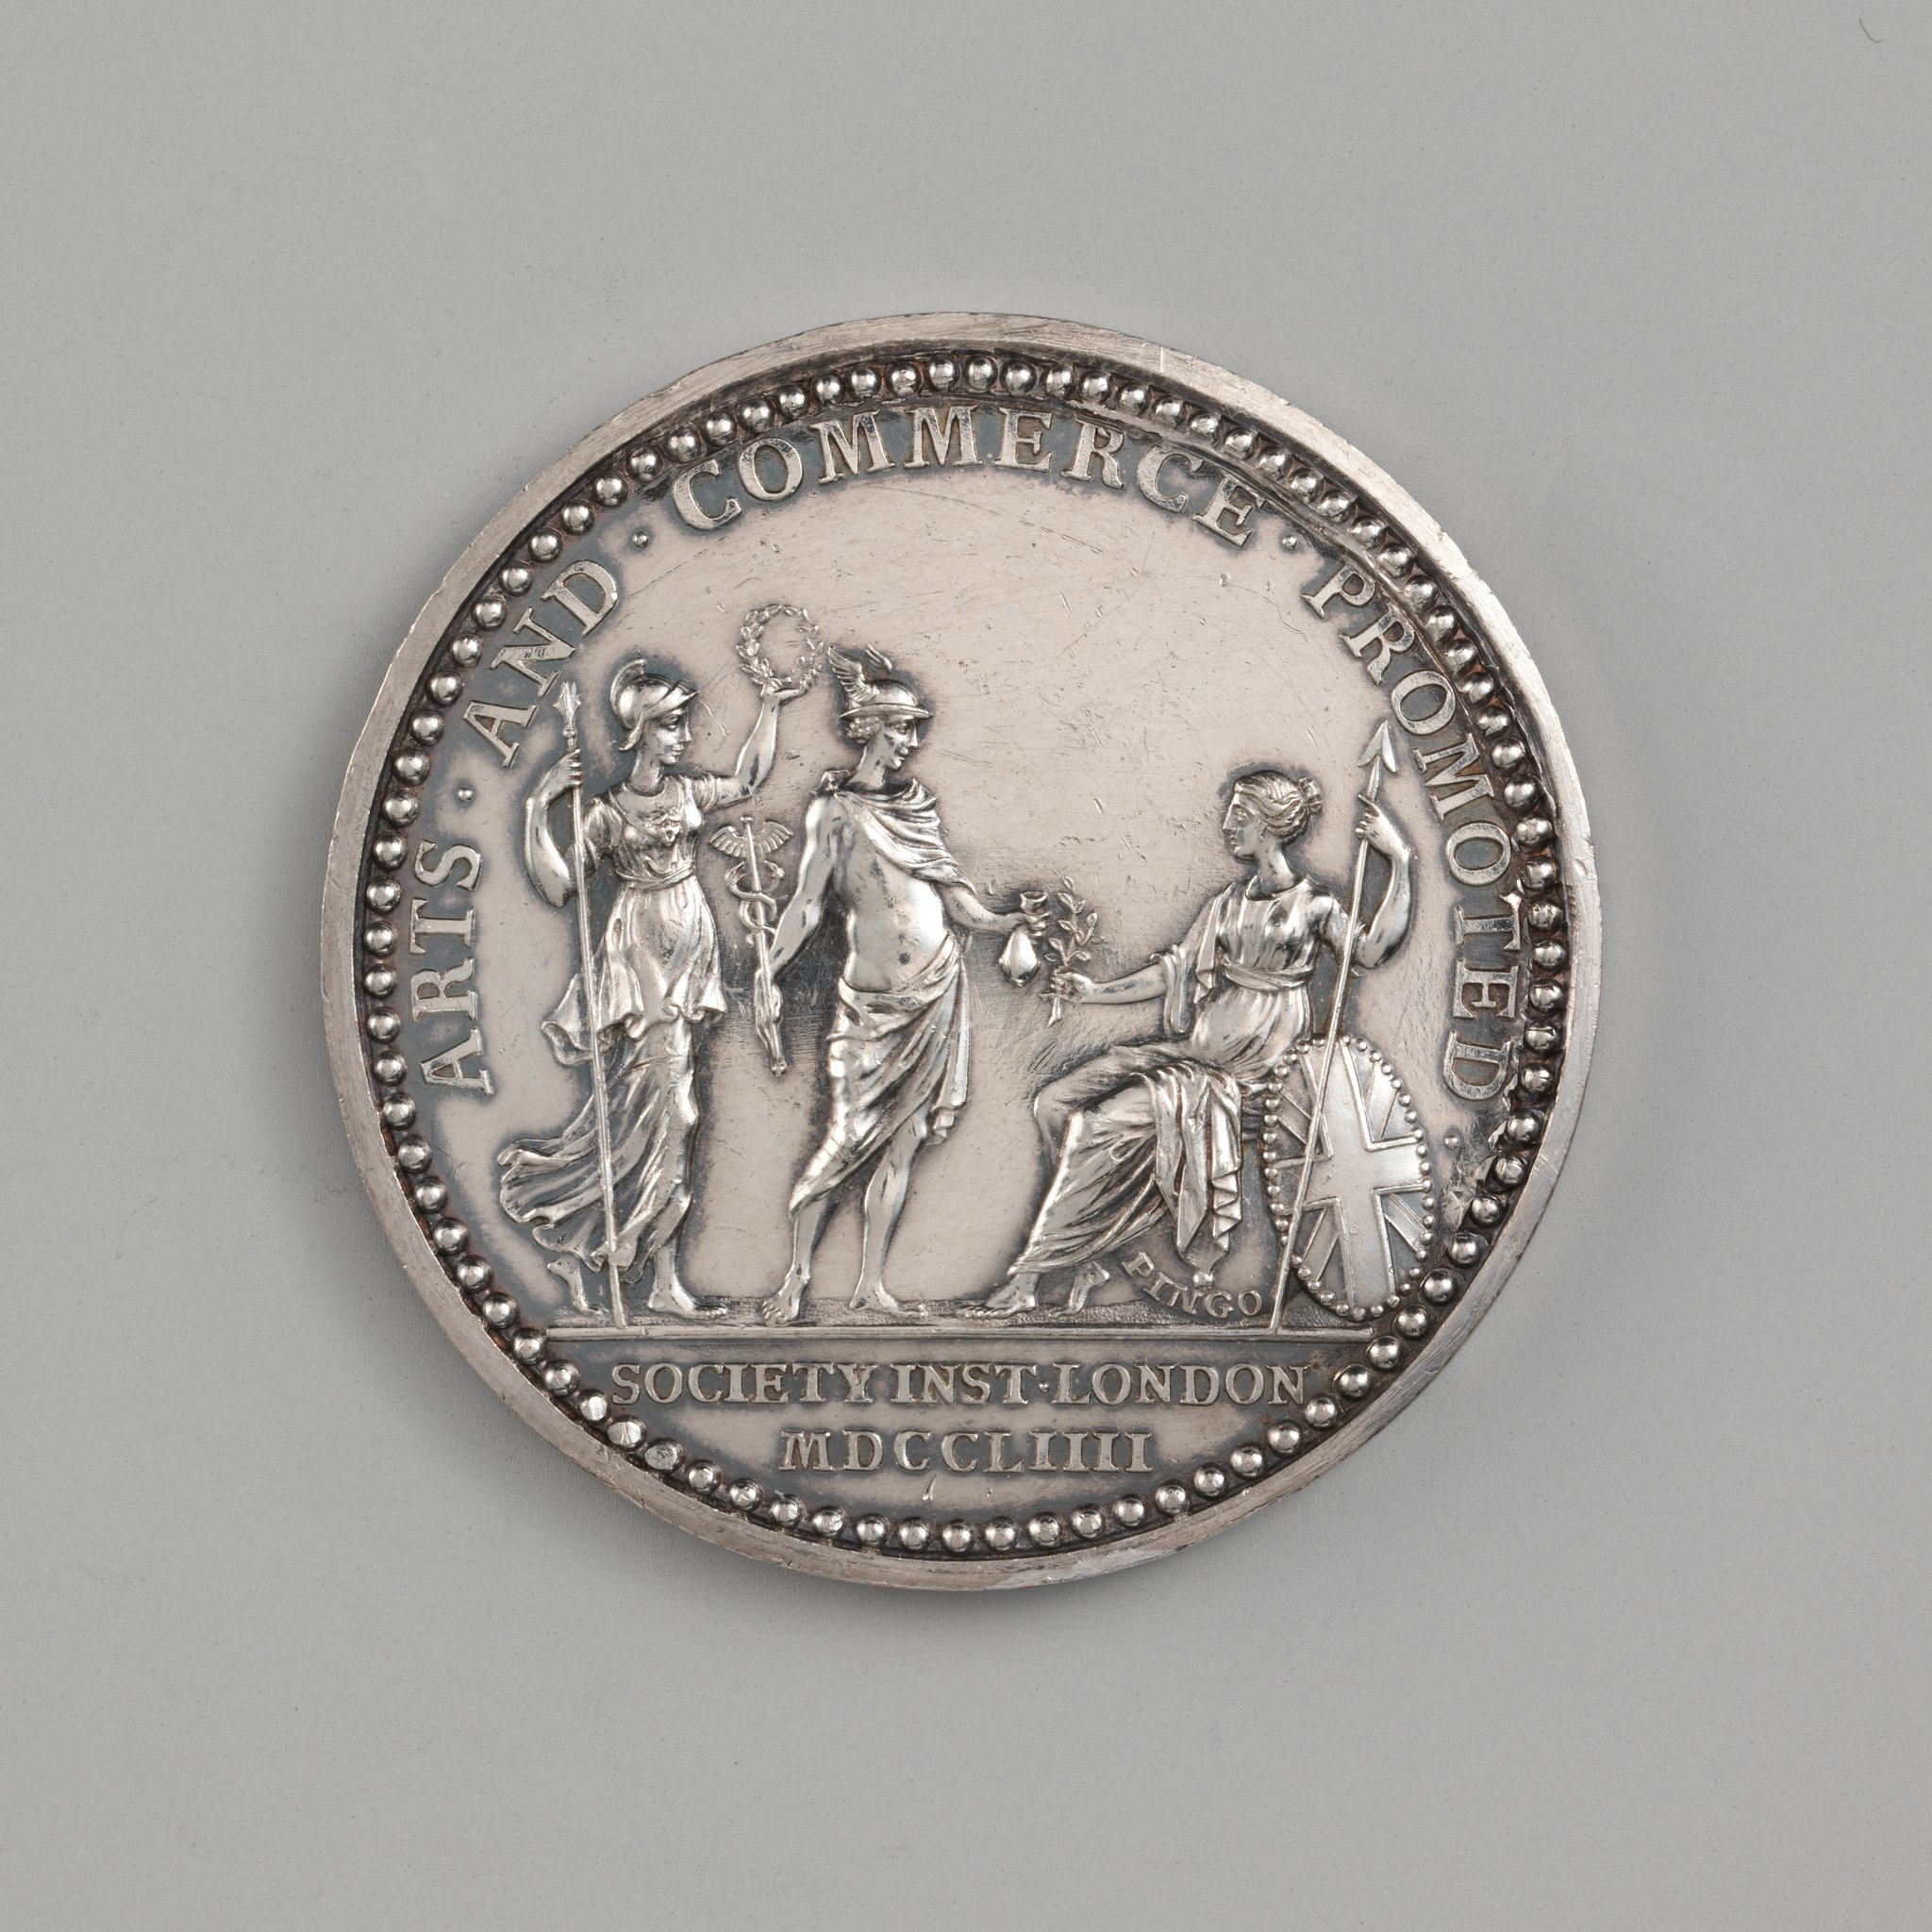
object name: medal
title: London Royal Society of Arts Medal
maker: thomas pingo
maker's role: artist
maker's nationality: italian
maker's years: 1692-1776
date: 1790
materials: silver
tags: shields,spears,men,women